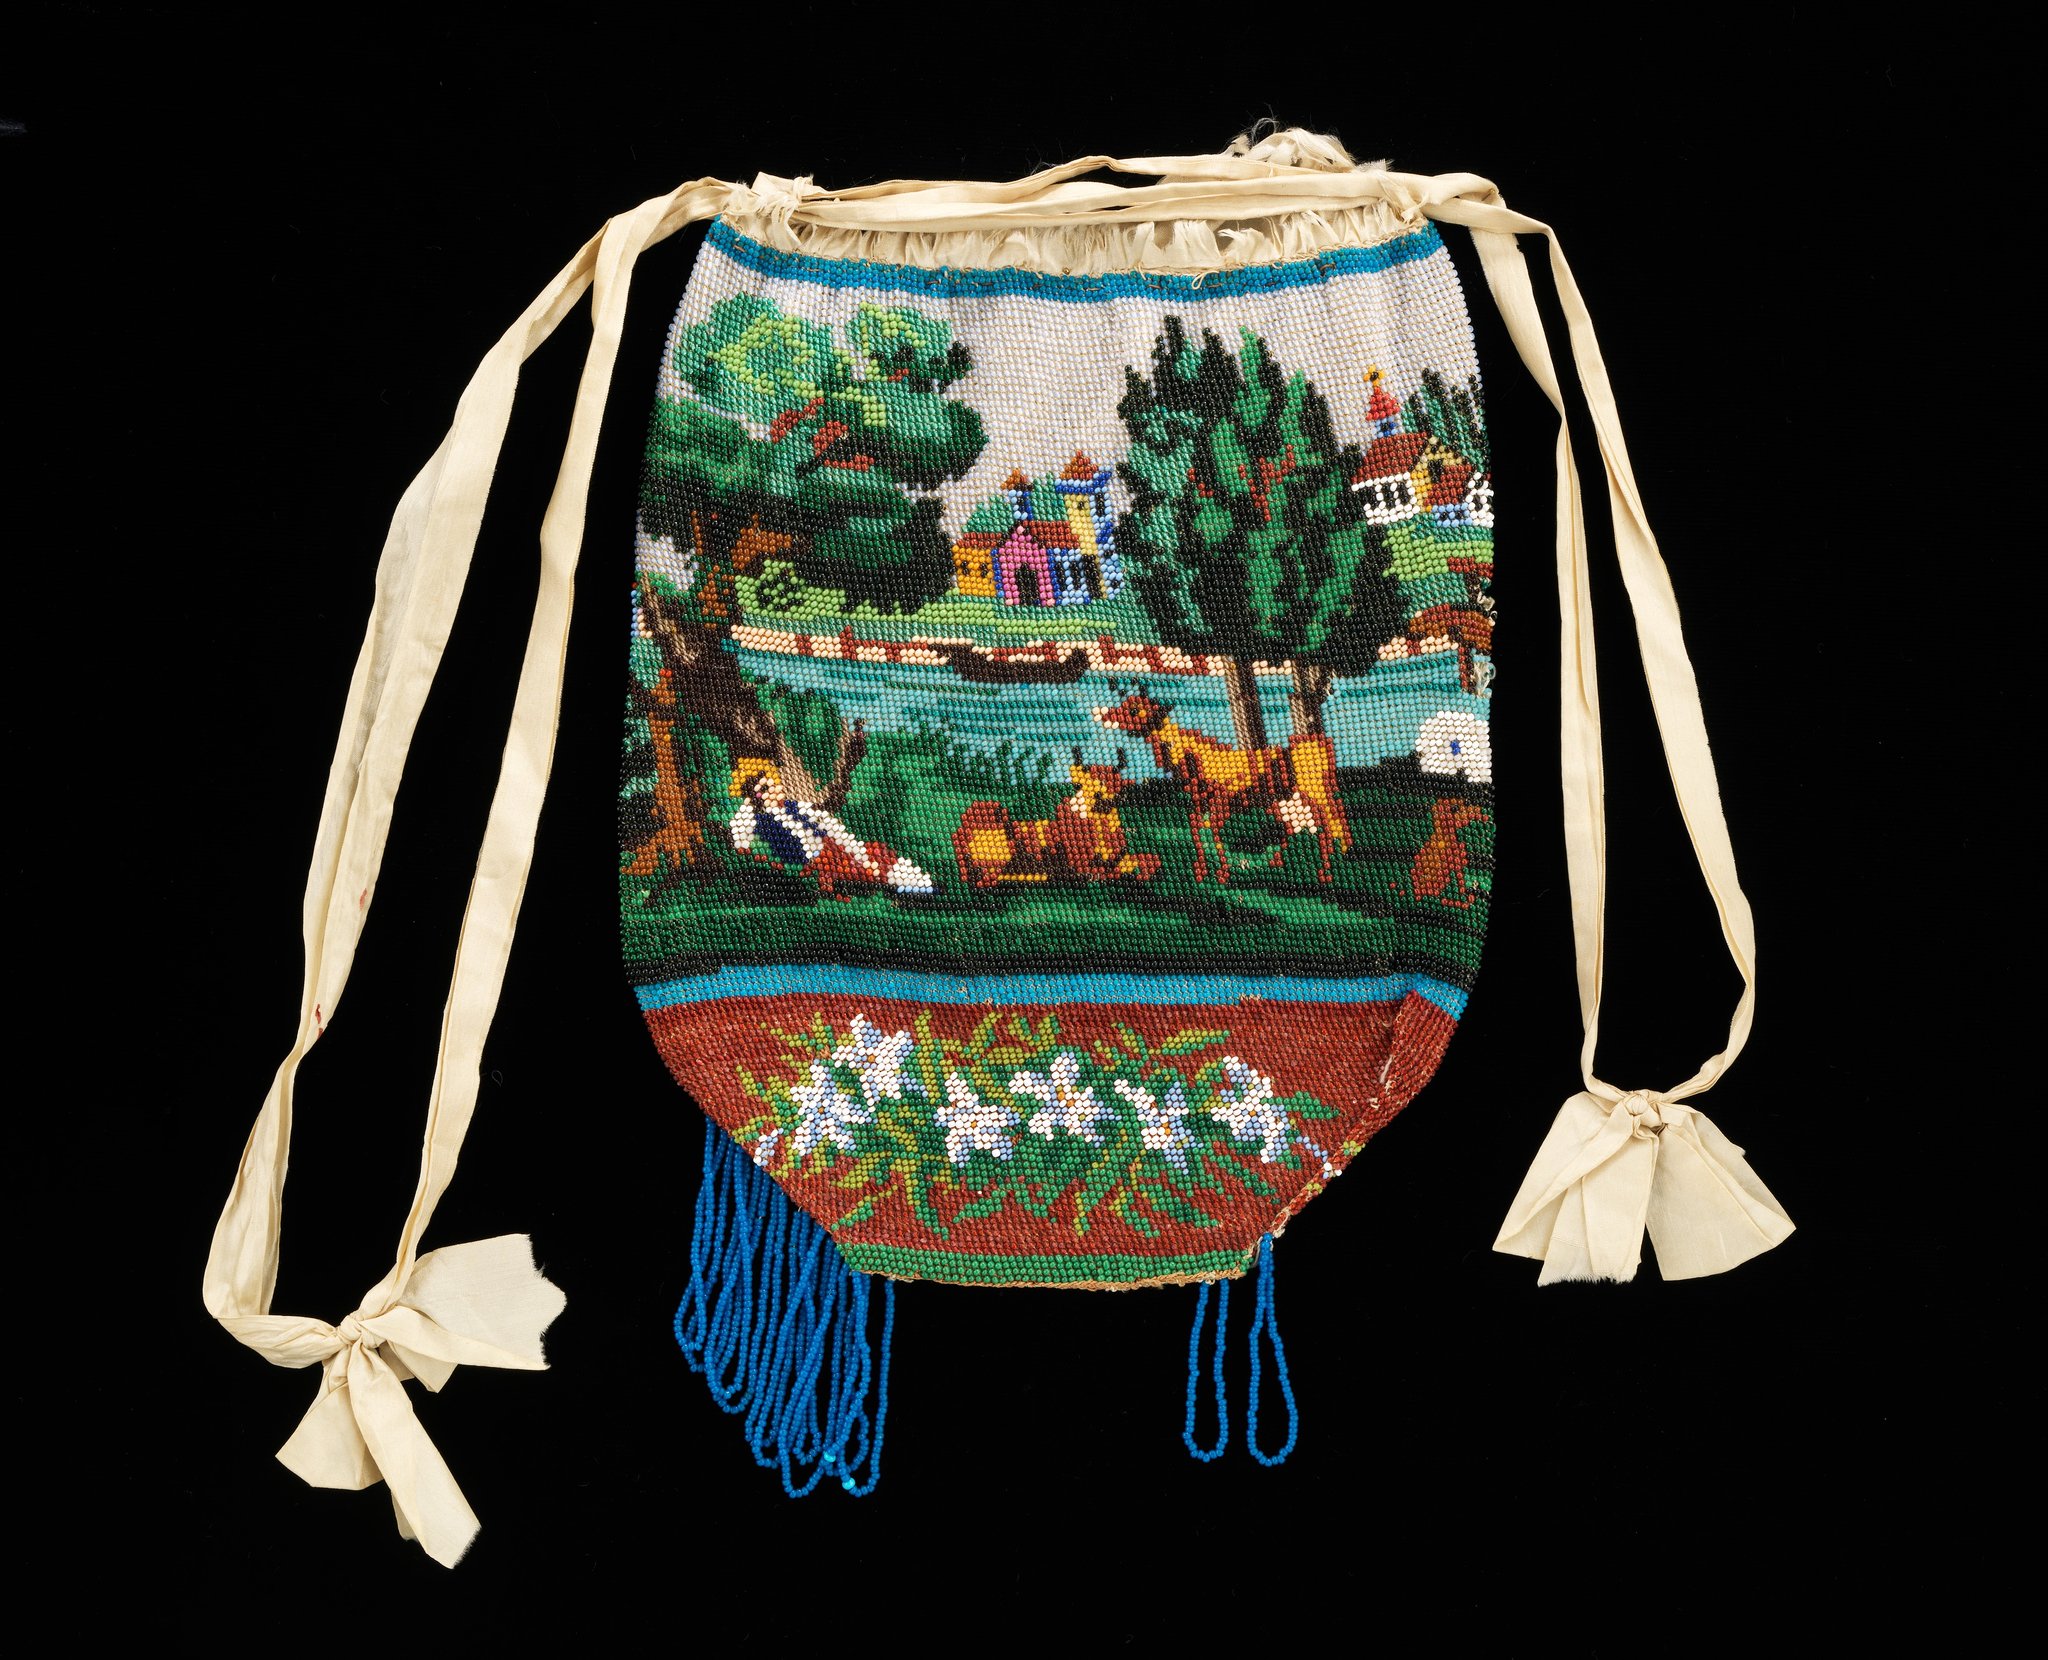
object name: pouch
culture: american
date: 1820-1840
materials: glass, linen, silk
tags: cows,shepherds